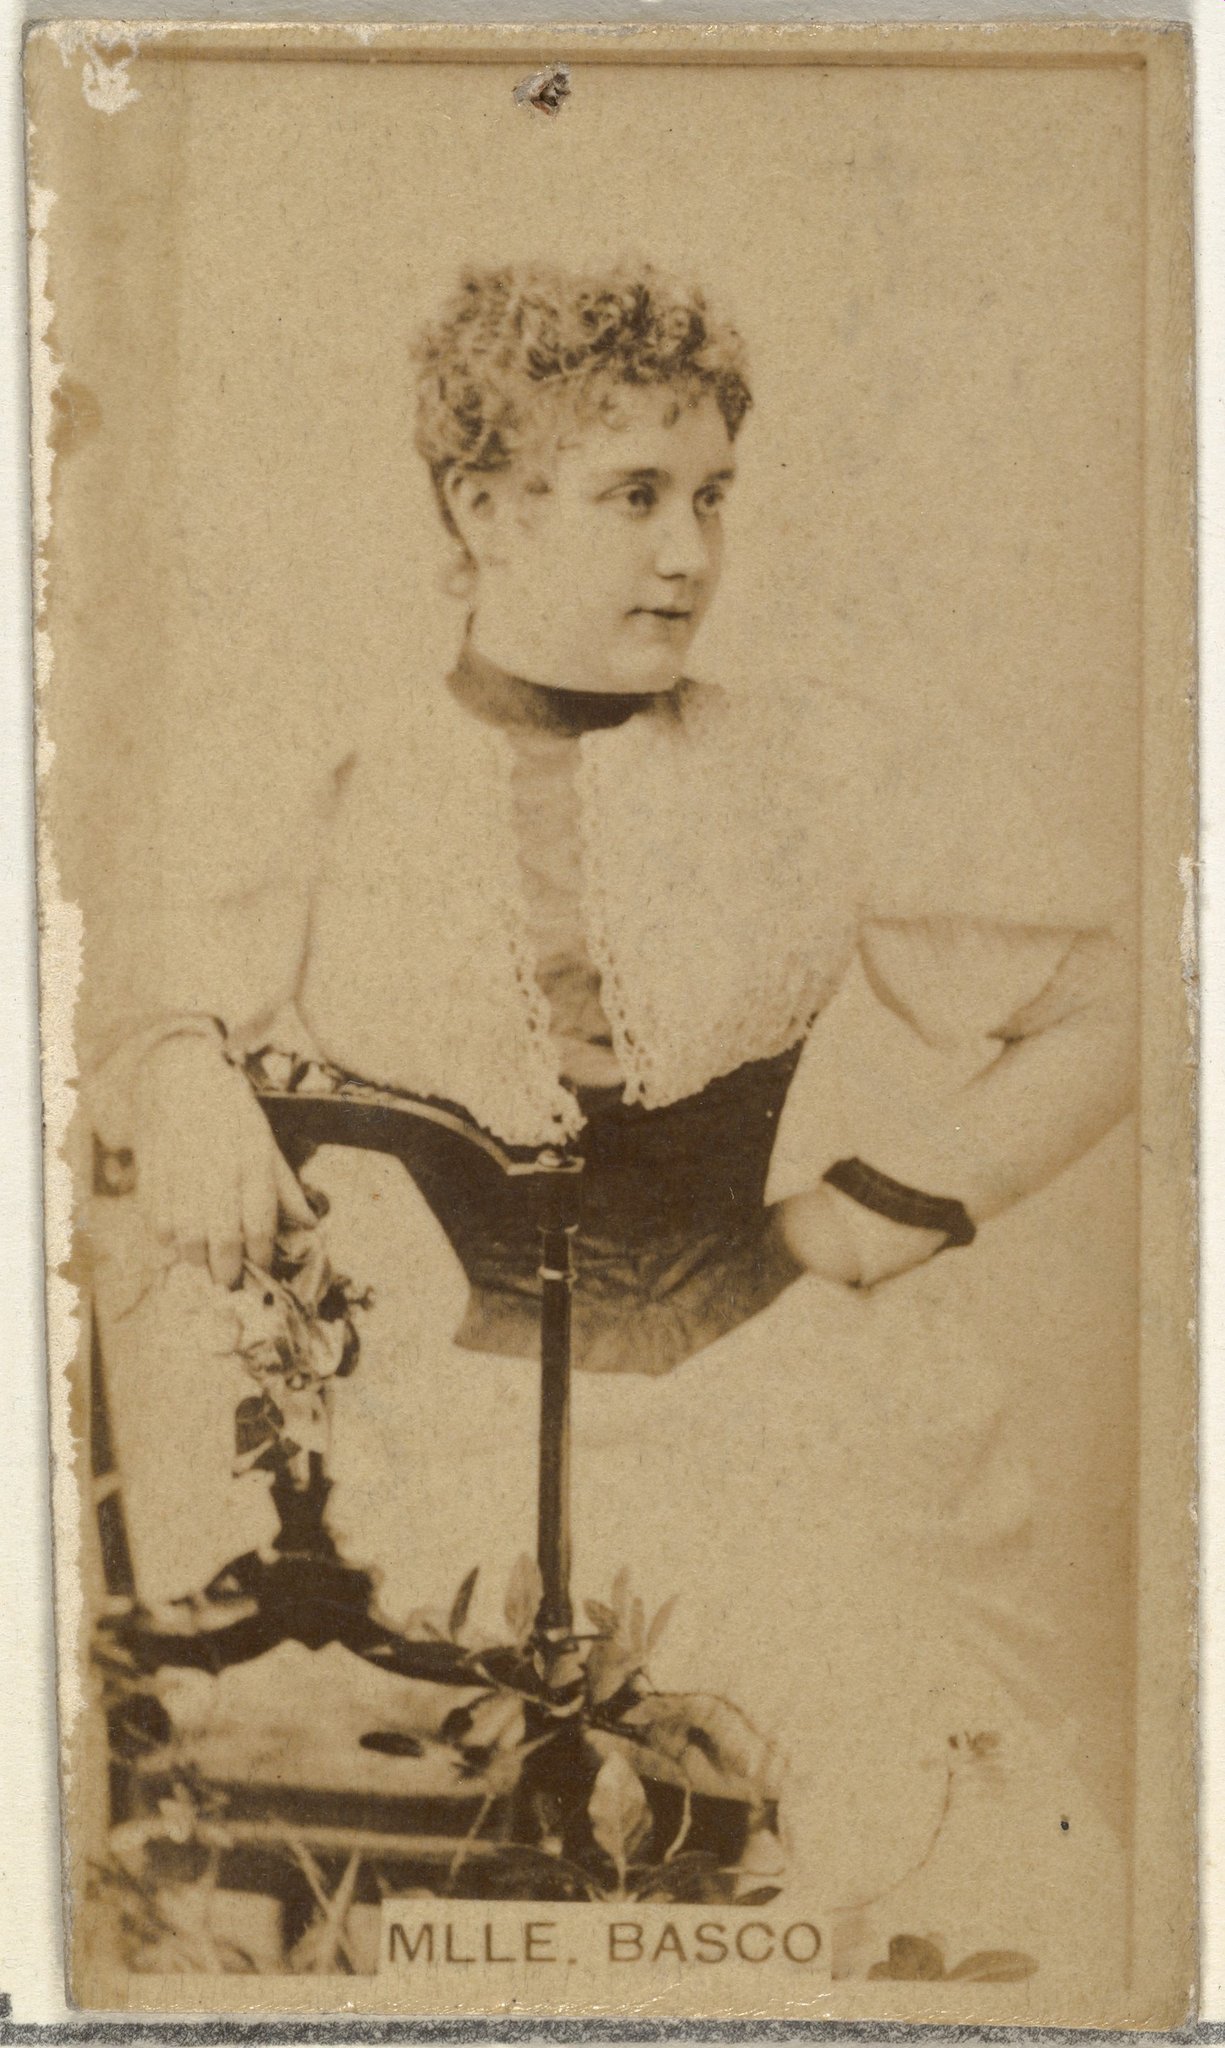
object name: photograph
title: Mlle. Basco, from the Actors and Actresses series (N145-8) issued by Duke Sons & Co. to promote Duke Cigarettes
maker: w. duke, sons & co.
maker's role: publisher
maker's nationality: american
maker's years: 1870-1920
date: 1891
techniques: albumen silver print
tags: portraits,women,actresses